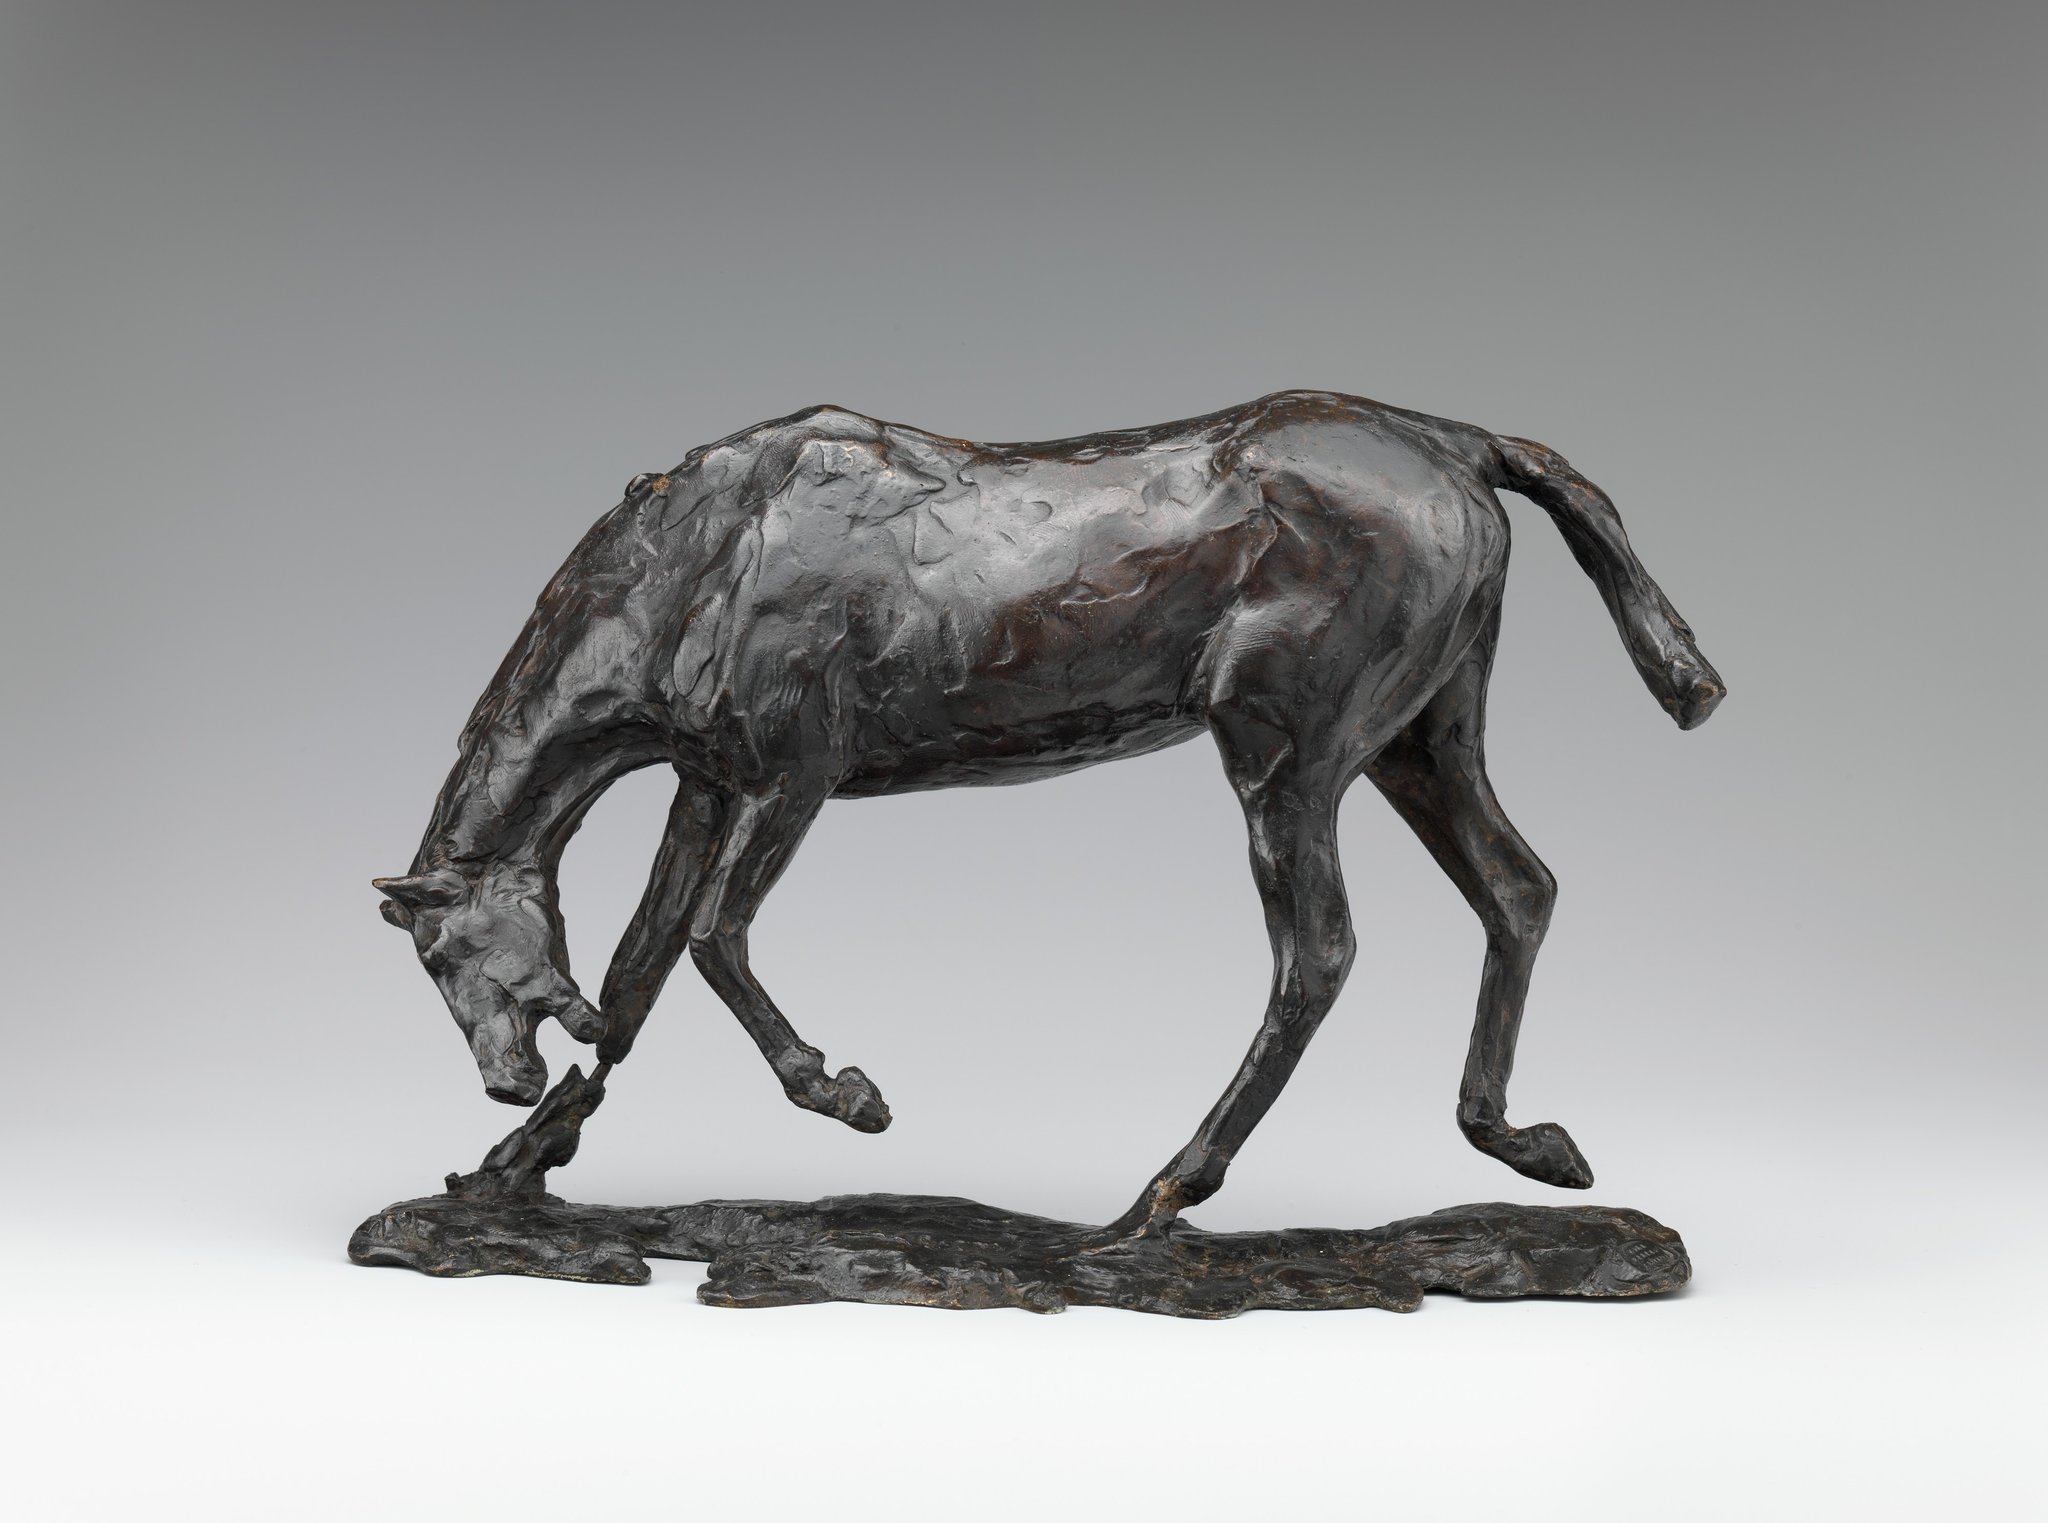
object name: statuette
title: Horse with Head Lowered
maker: edgar degas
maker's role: artist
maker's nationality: french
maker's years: 1834-1917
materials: bronze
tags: horses